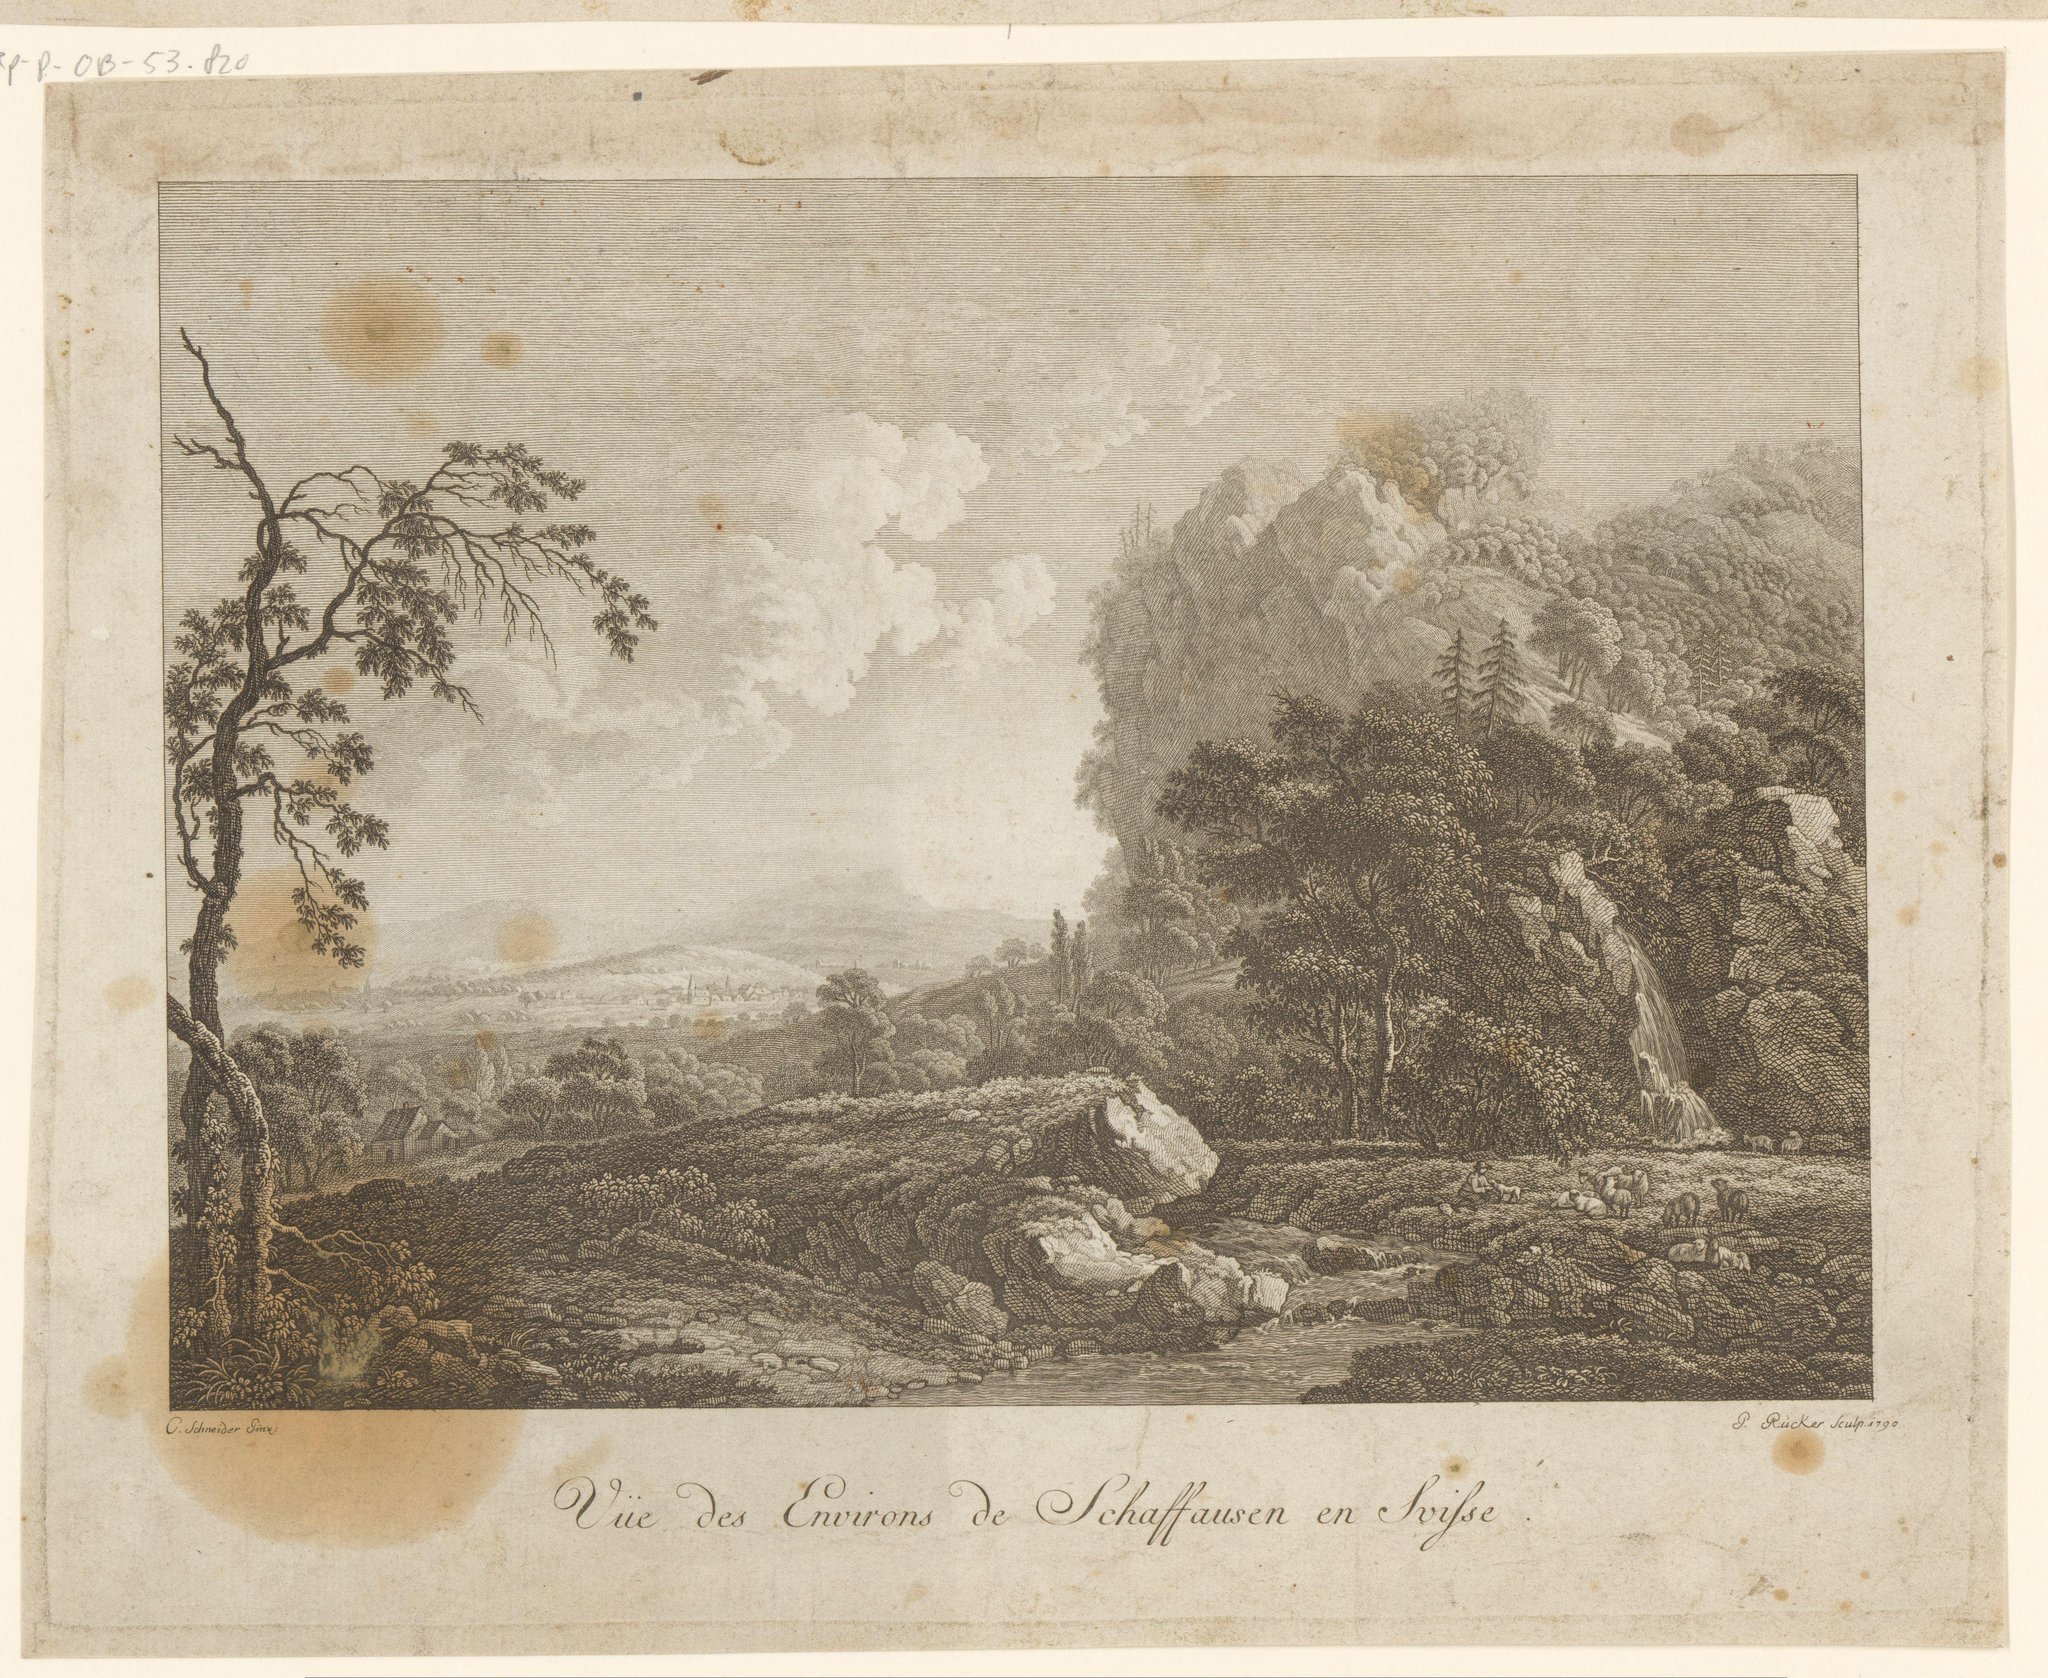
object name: print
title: Gezicht op het landschap in de omgeving van Schaffhausen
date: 1790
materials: paper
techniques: etching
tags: landscapes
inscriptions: collector's mark: Lugt 2228